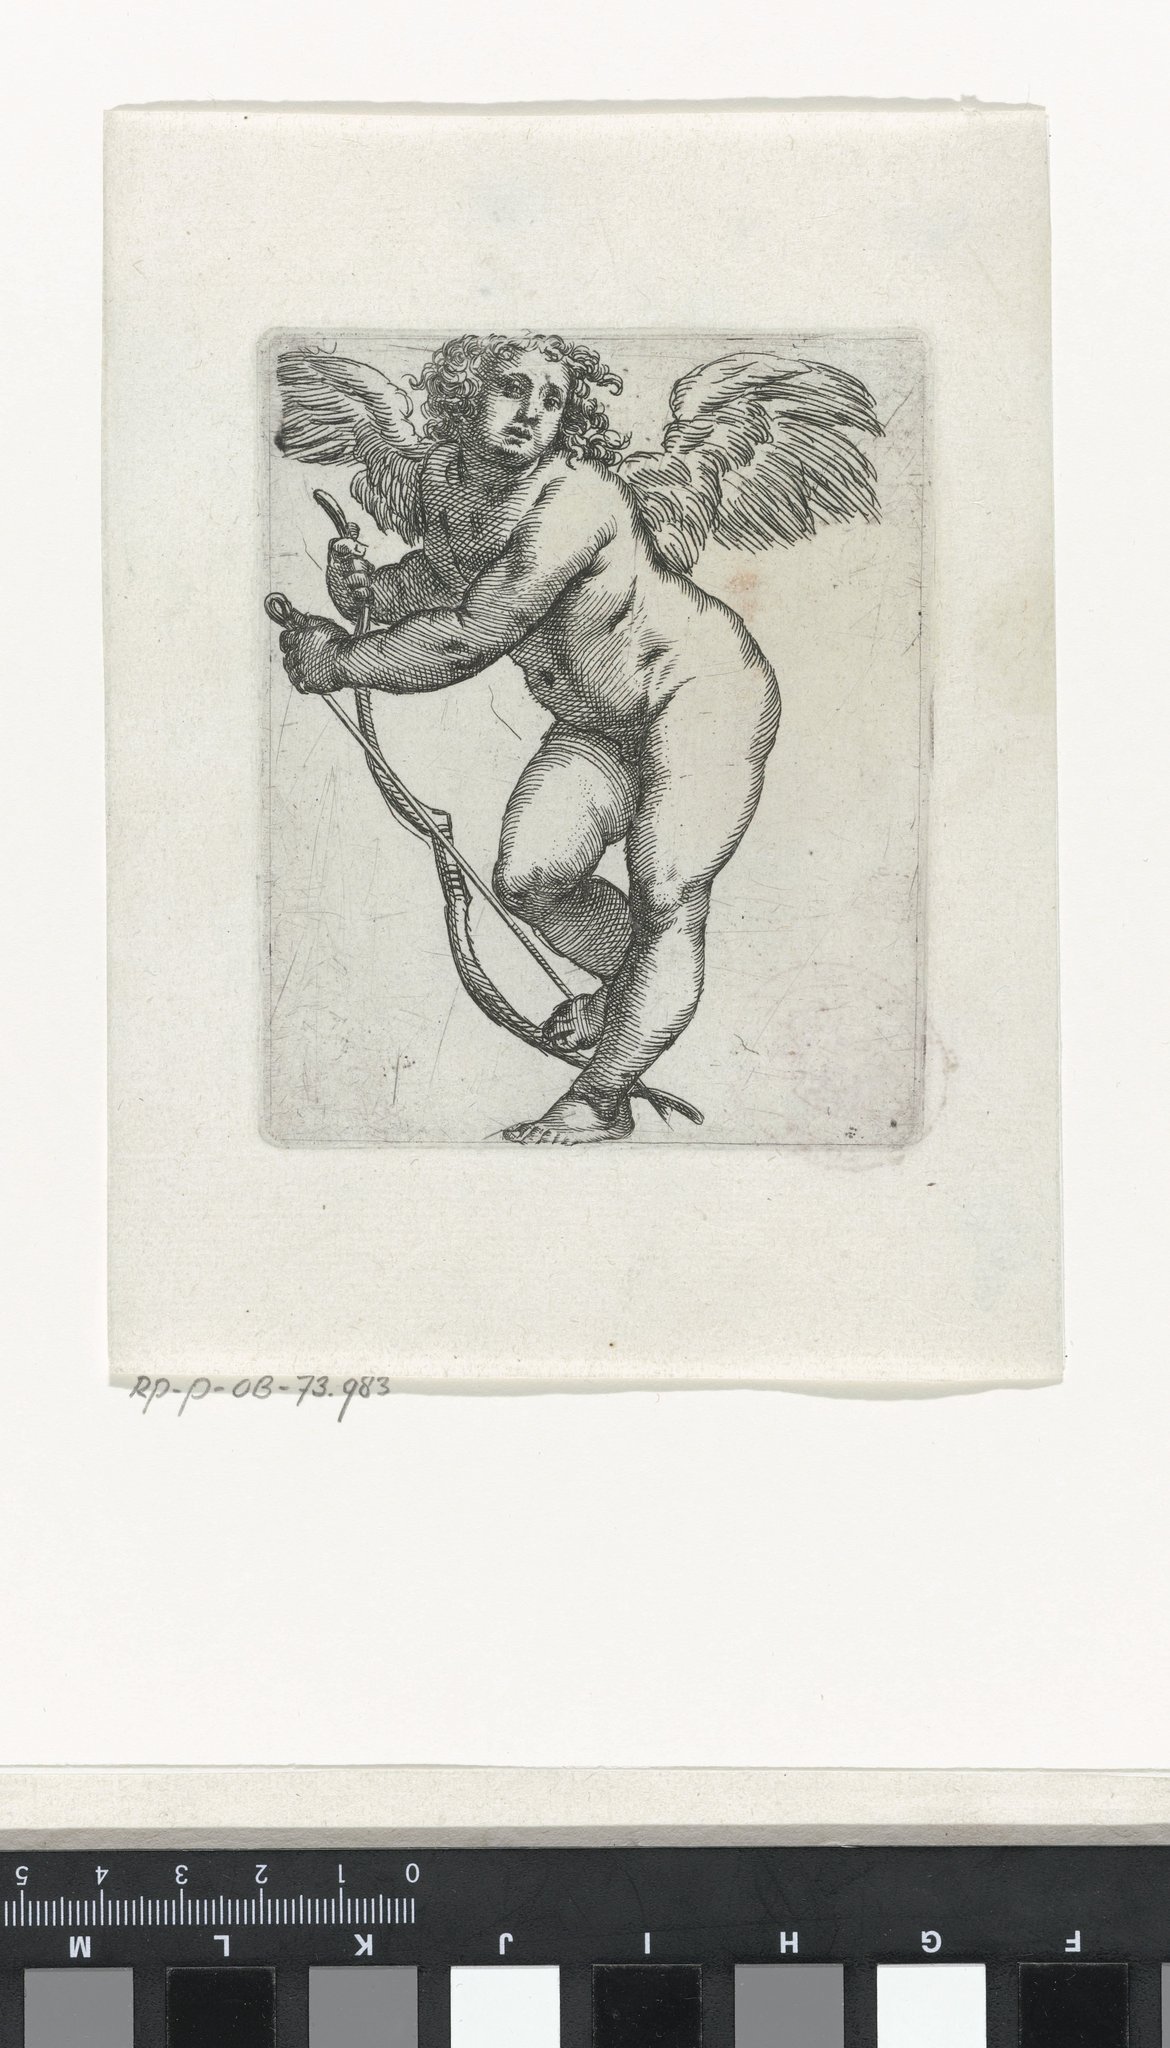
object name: print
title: Amor spant zijn boog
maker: Anonymous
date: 1600-1700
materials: paper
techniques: etching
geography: netherlands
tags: (story of) cupid, amor (eros)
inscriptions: collector's mark: Lugt 240